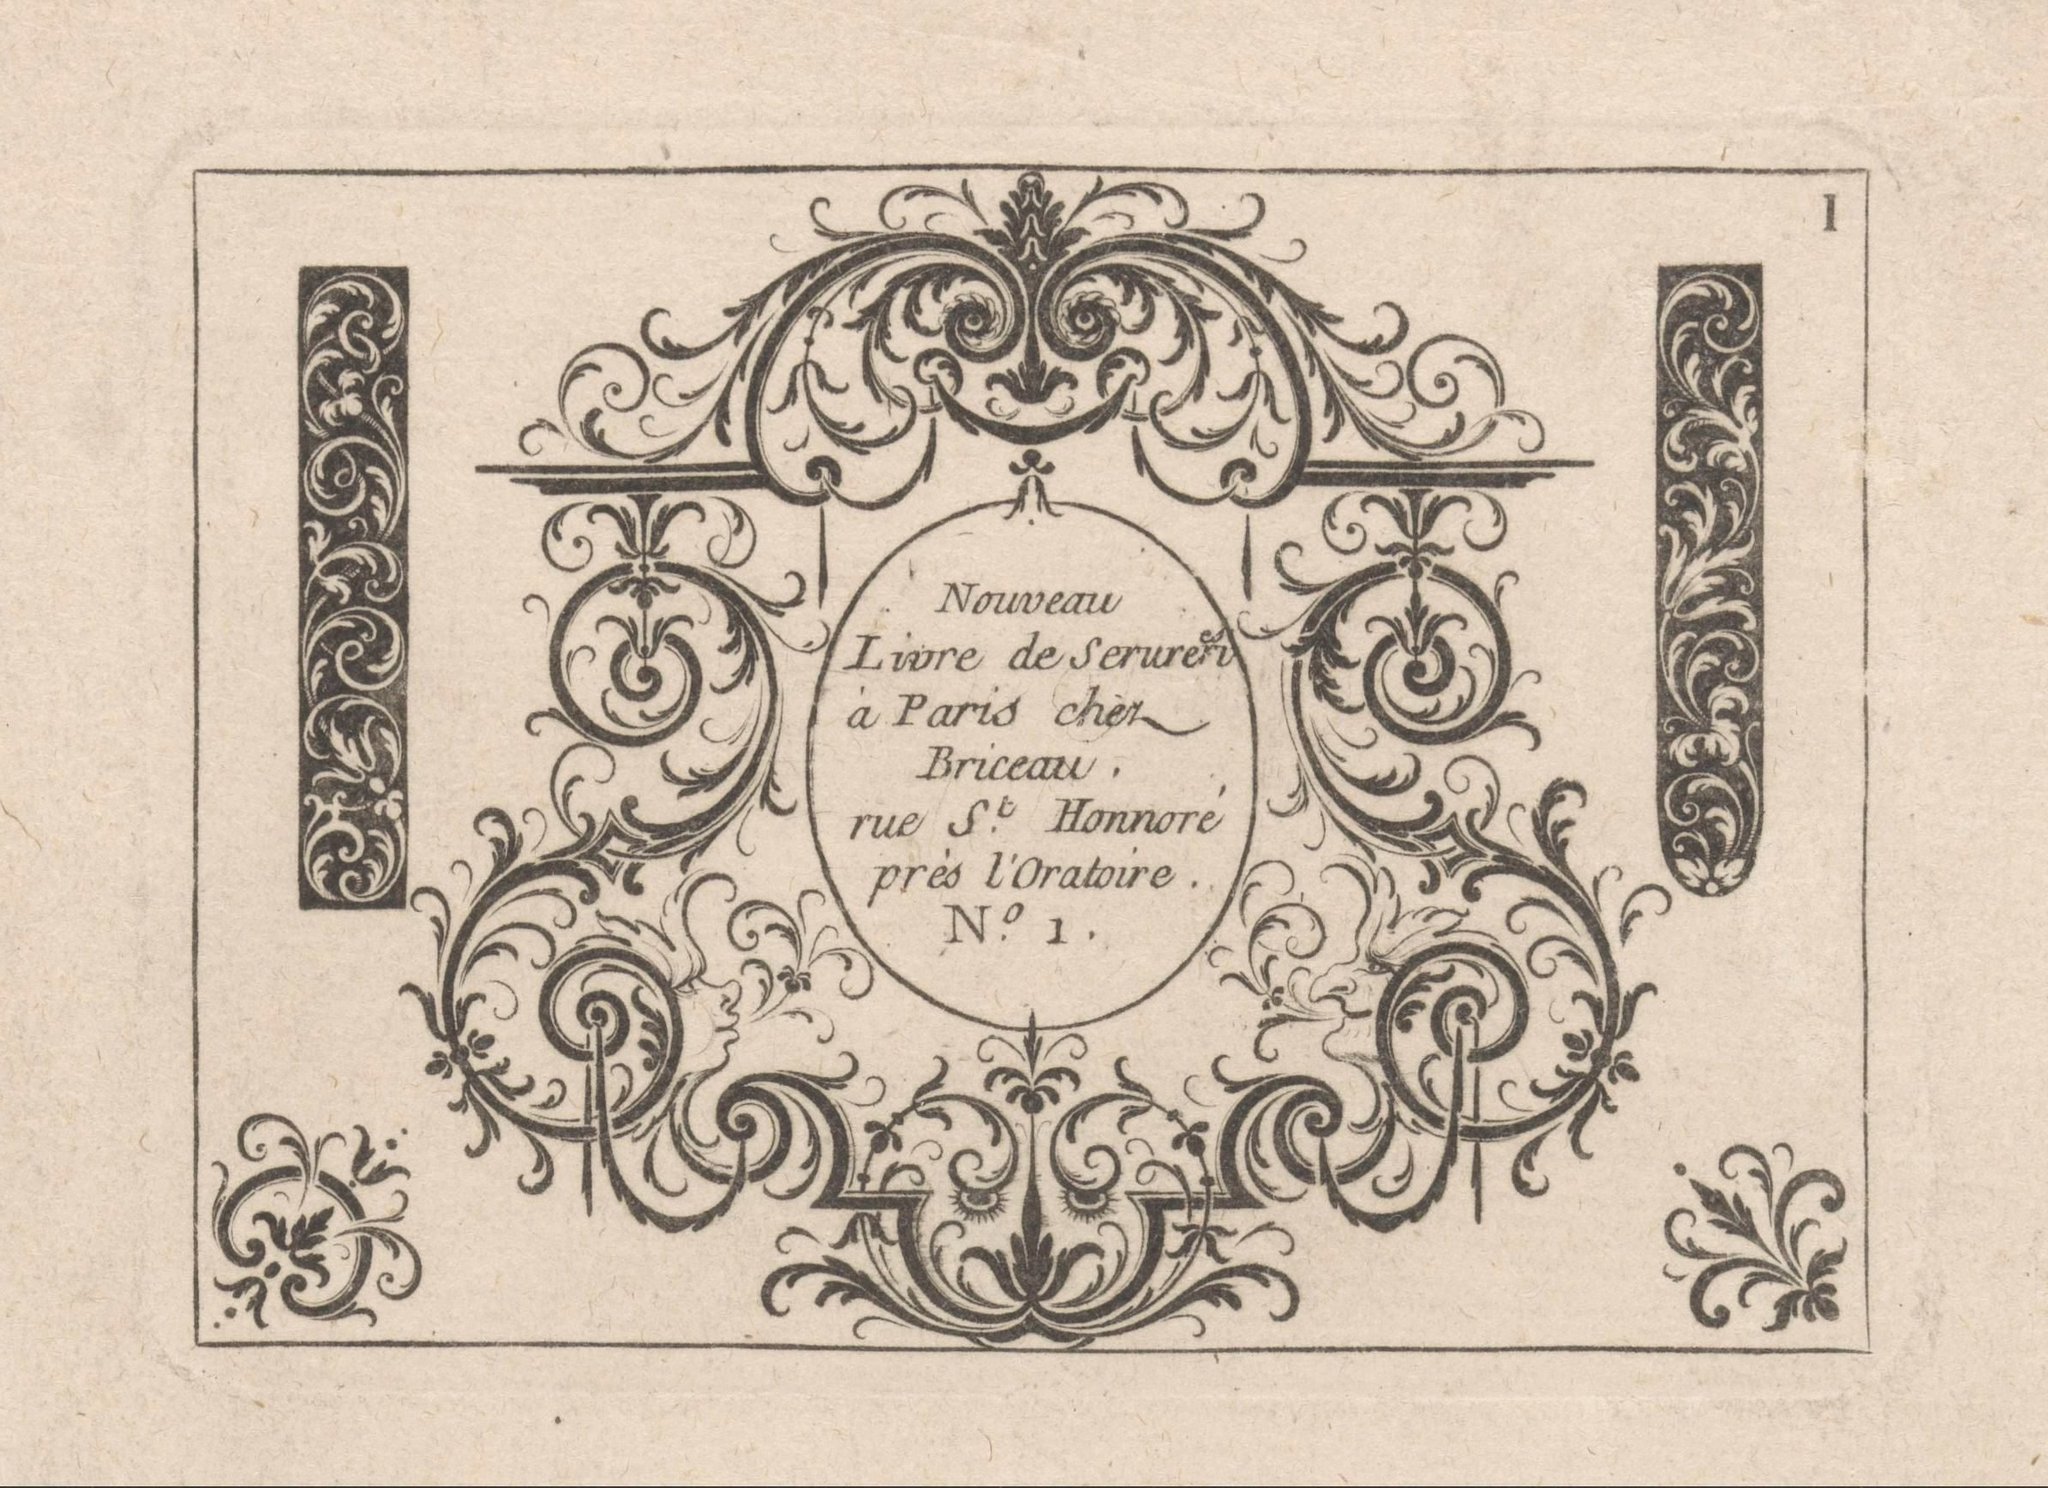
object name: titelprent, frontispice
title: Medaillon en vlechtwerk met gezichten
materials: paper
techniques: etching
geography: paris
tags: face, interlace ~ ornament, ornament ~ medallion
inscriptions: collector's mark: Lugt 2228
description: In het midden een ovaal medaillon met de serietitel, omringd door vlechtwerk met links- en rechts onder gezichten.